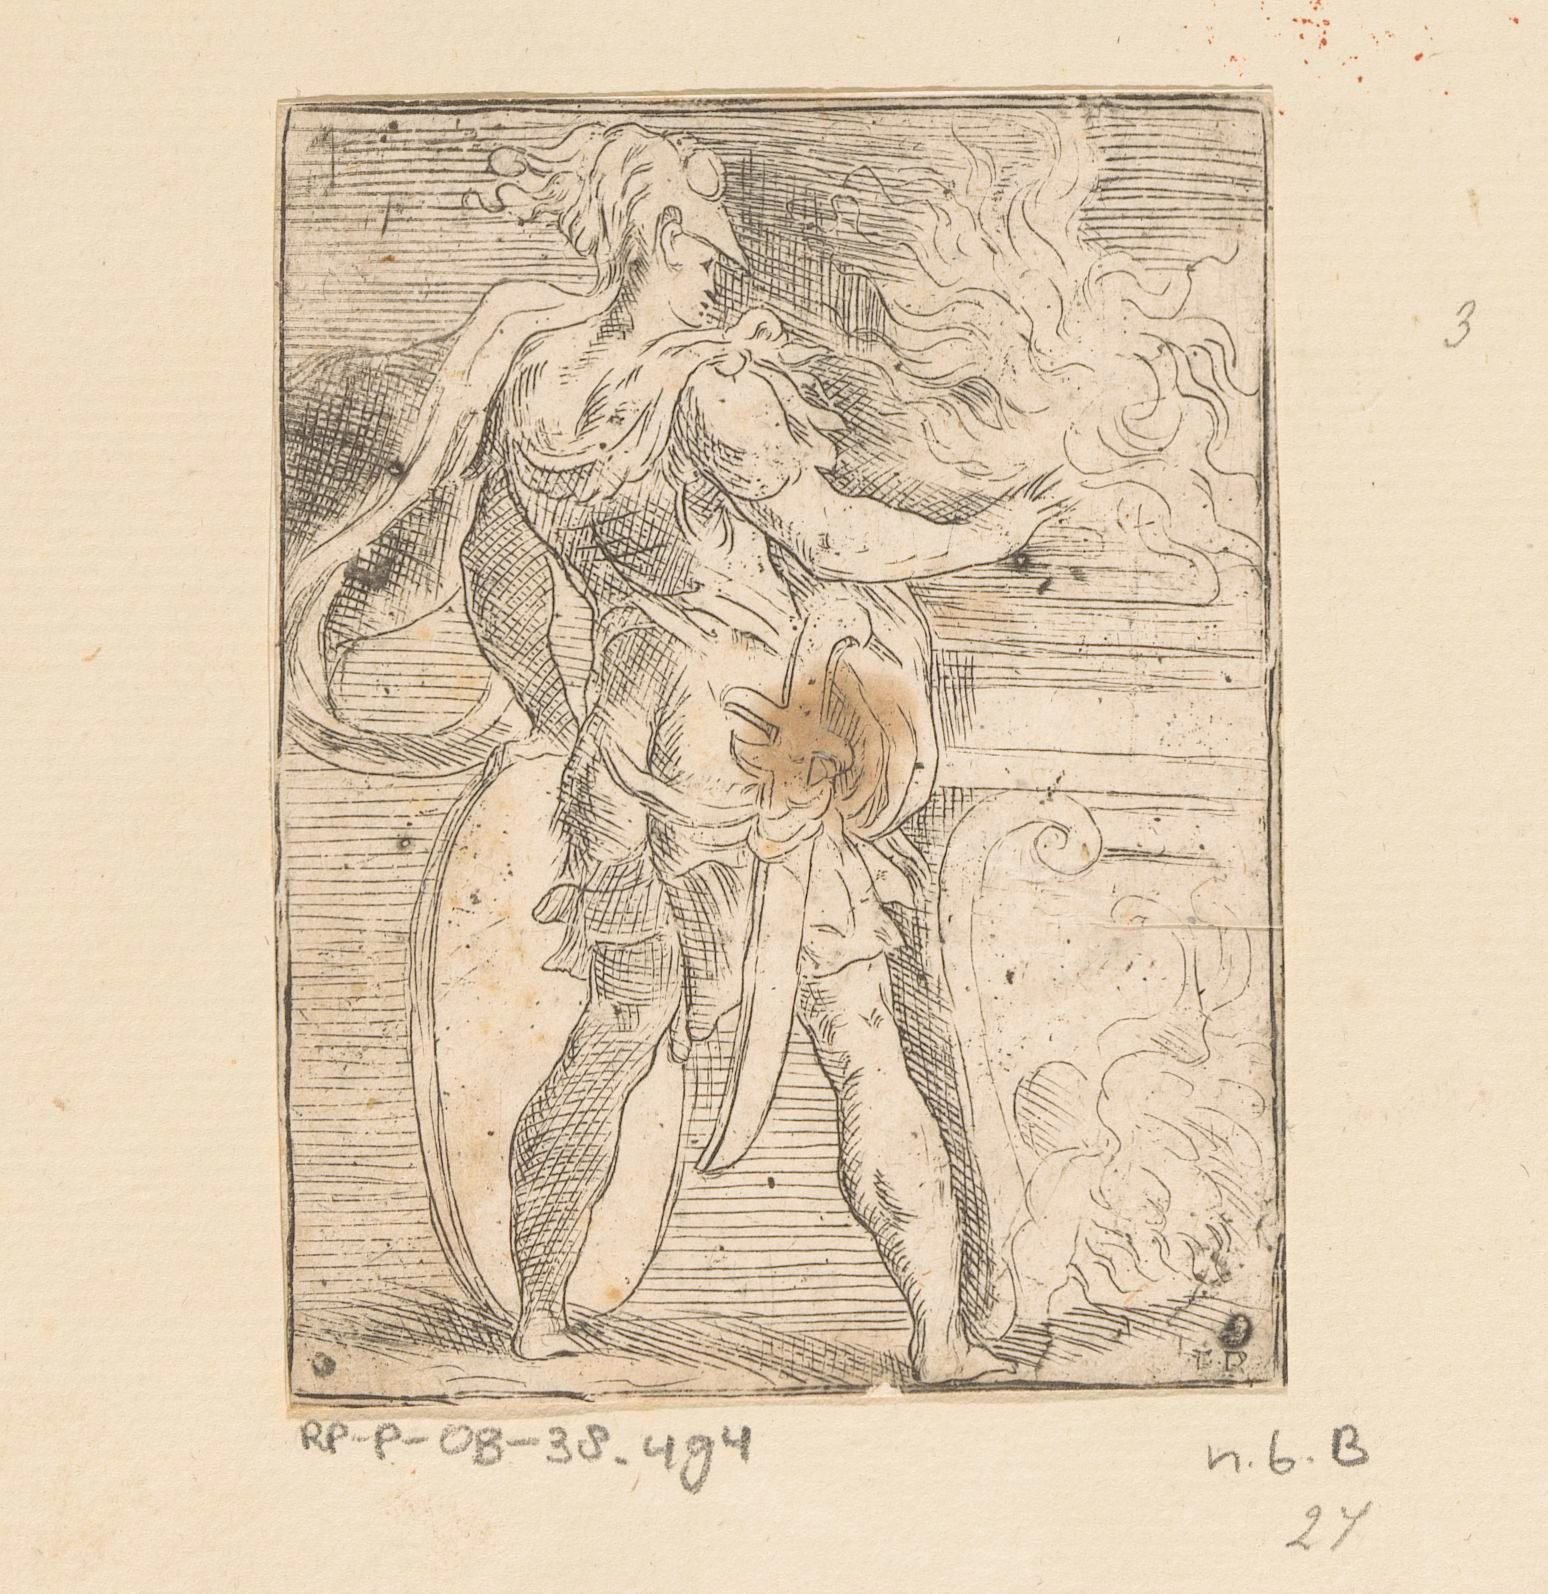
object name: print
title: Strijder bij een altaar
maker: monogrammist fp (italië; 16e eeuw)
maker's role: print maker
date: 1500-1599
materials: paper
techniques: etching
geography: italy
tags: the soldier; the soldier's life, altar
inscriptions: collector's mark: Lugt 240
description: Een gewapende strijder, op de rug gezien, staand bij een altaar met een brandend vuur.